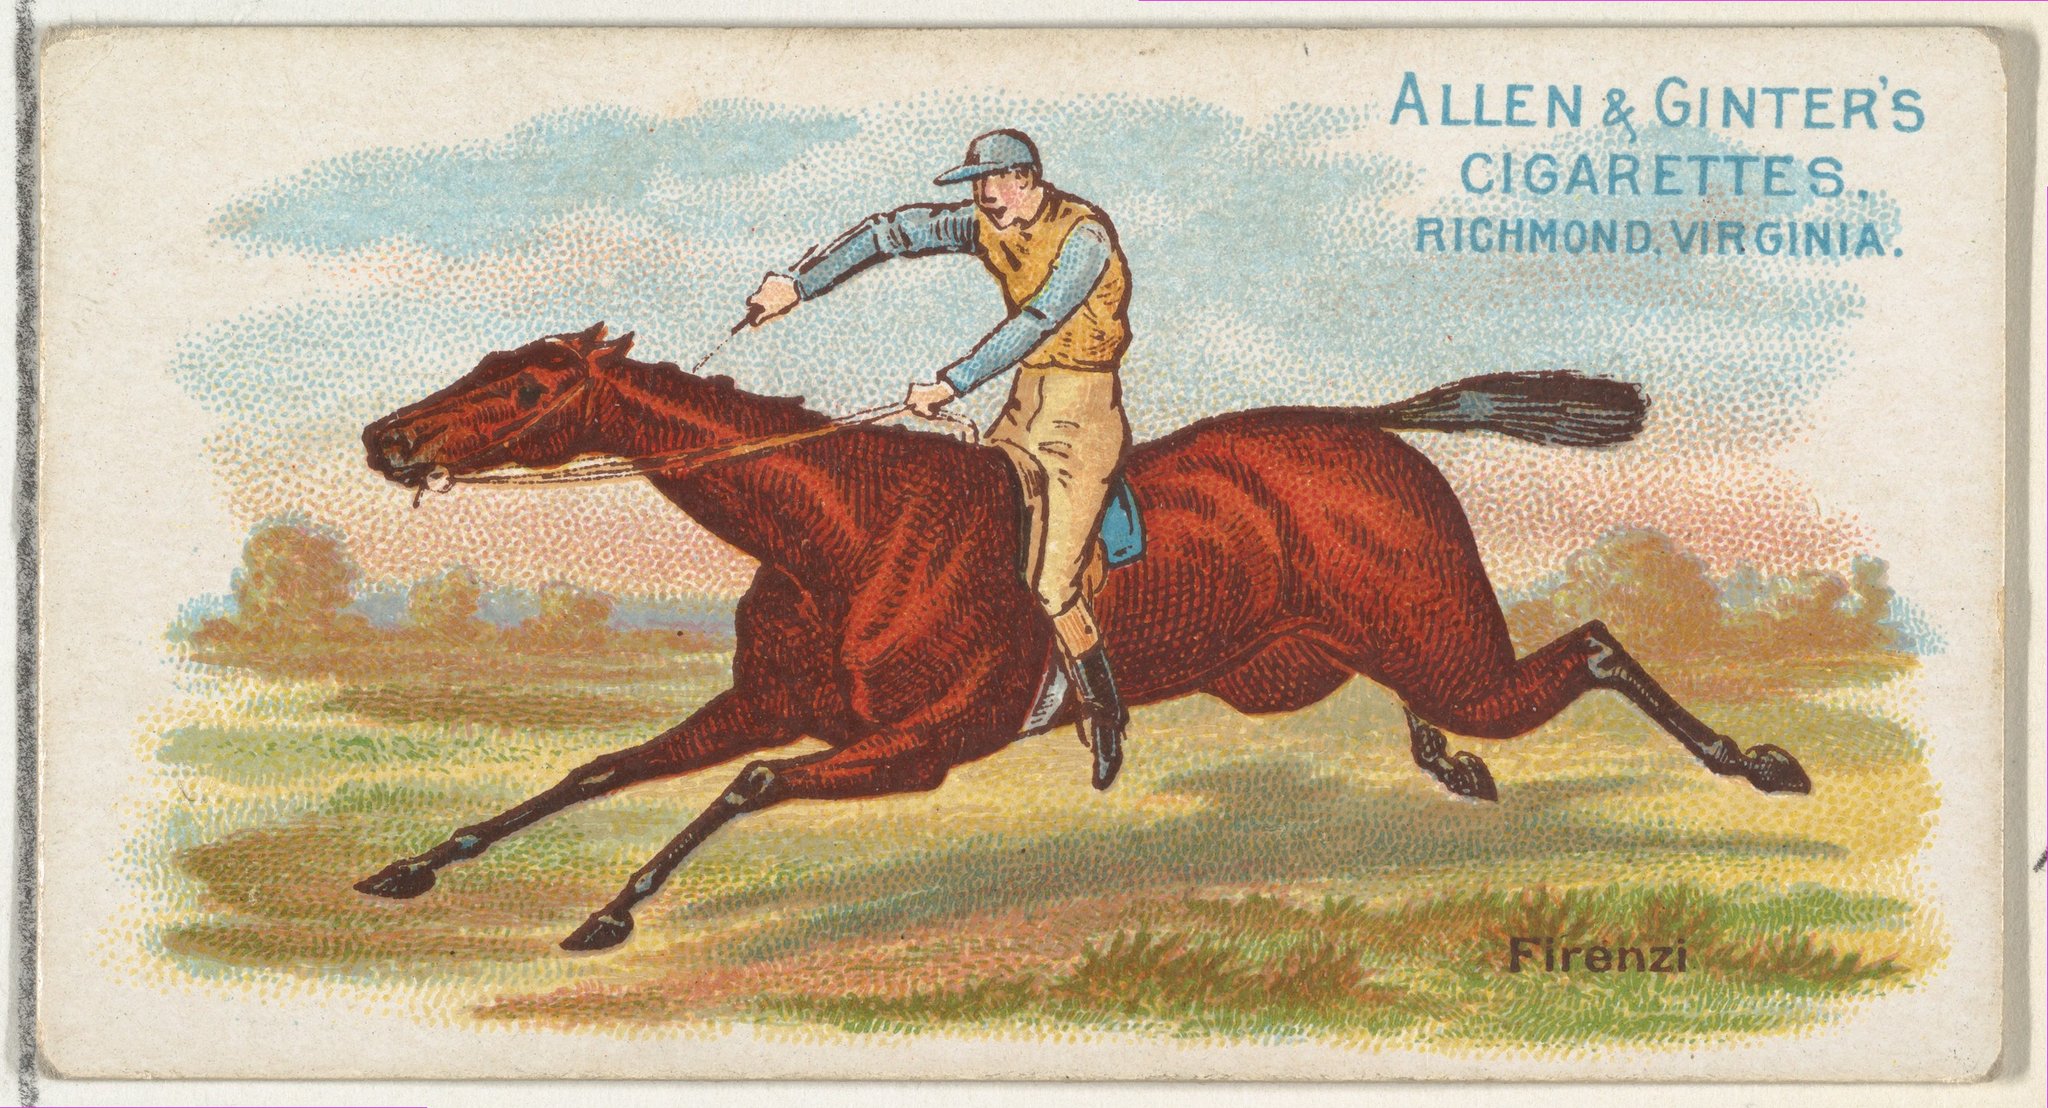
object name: print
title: Firenzi, from The World's Racers series (N32) for Allen & Ginter Cigarettes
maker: allen & ginter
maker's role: publisher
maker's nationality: american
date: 1888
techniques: color lithograph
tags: men,horses,jockeys